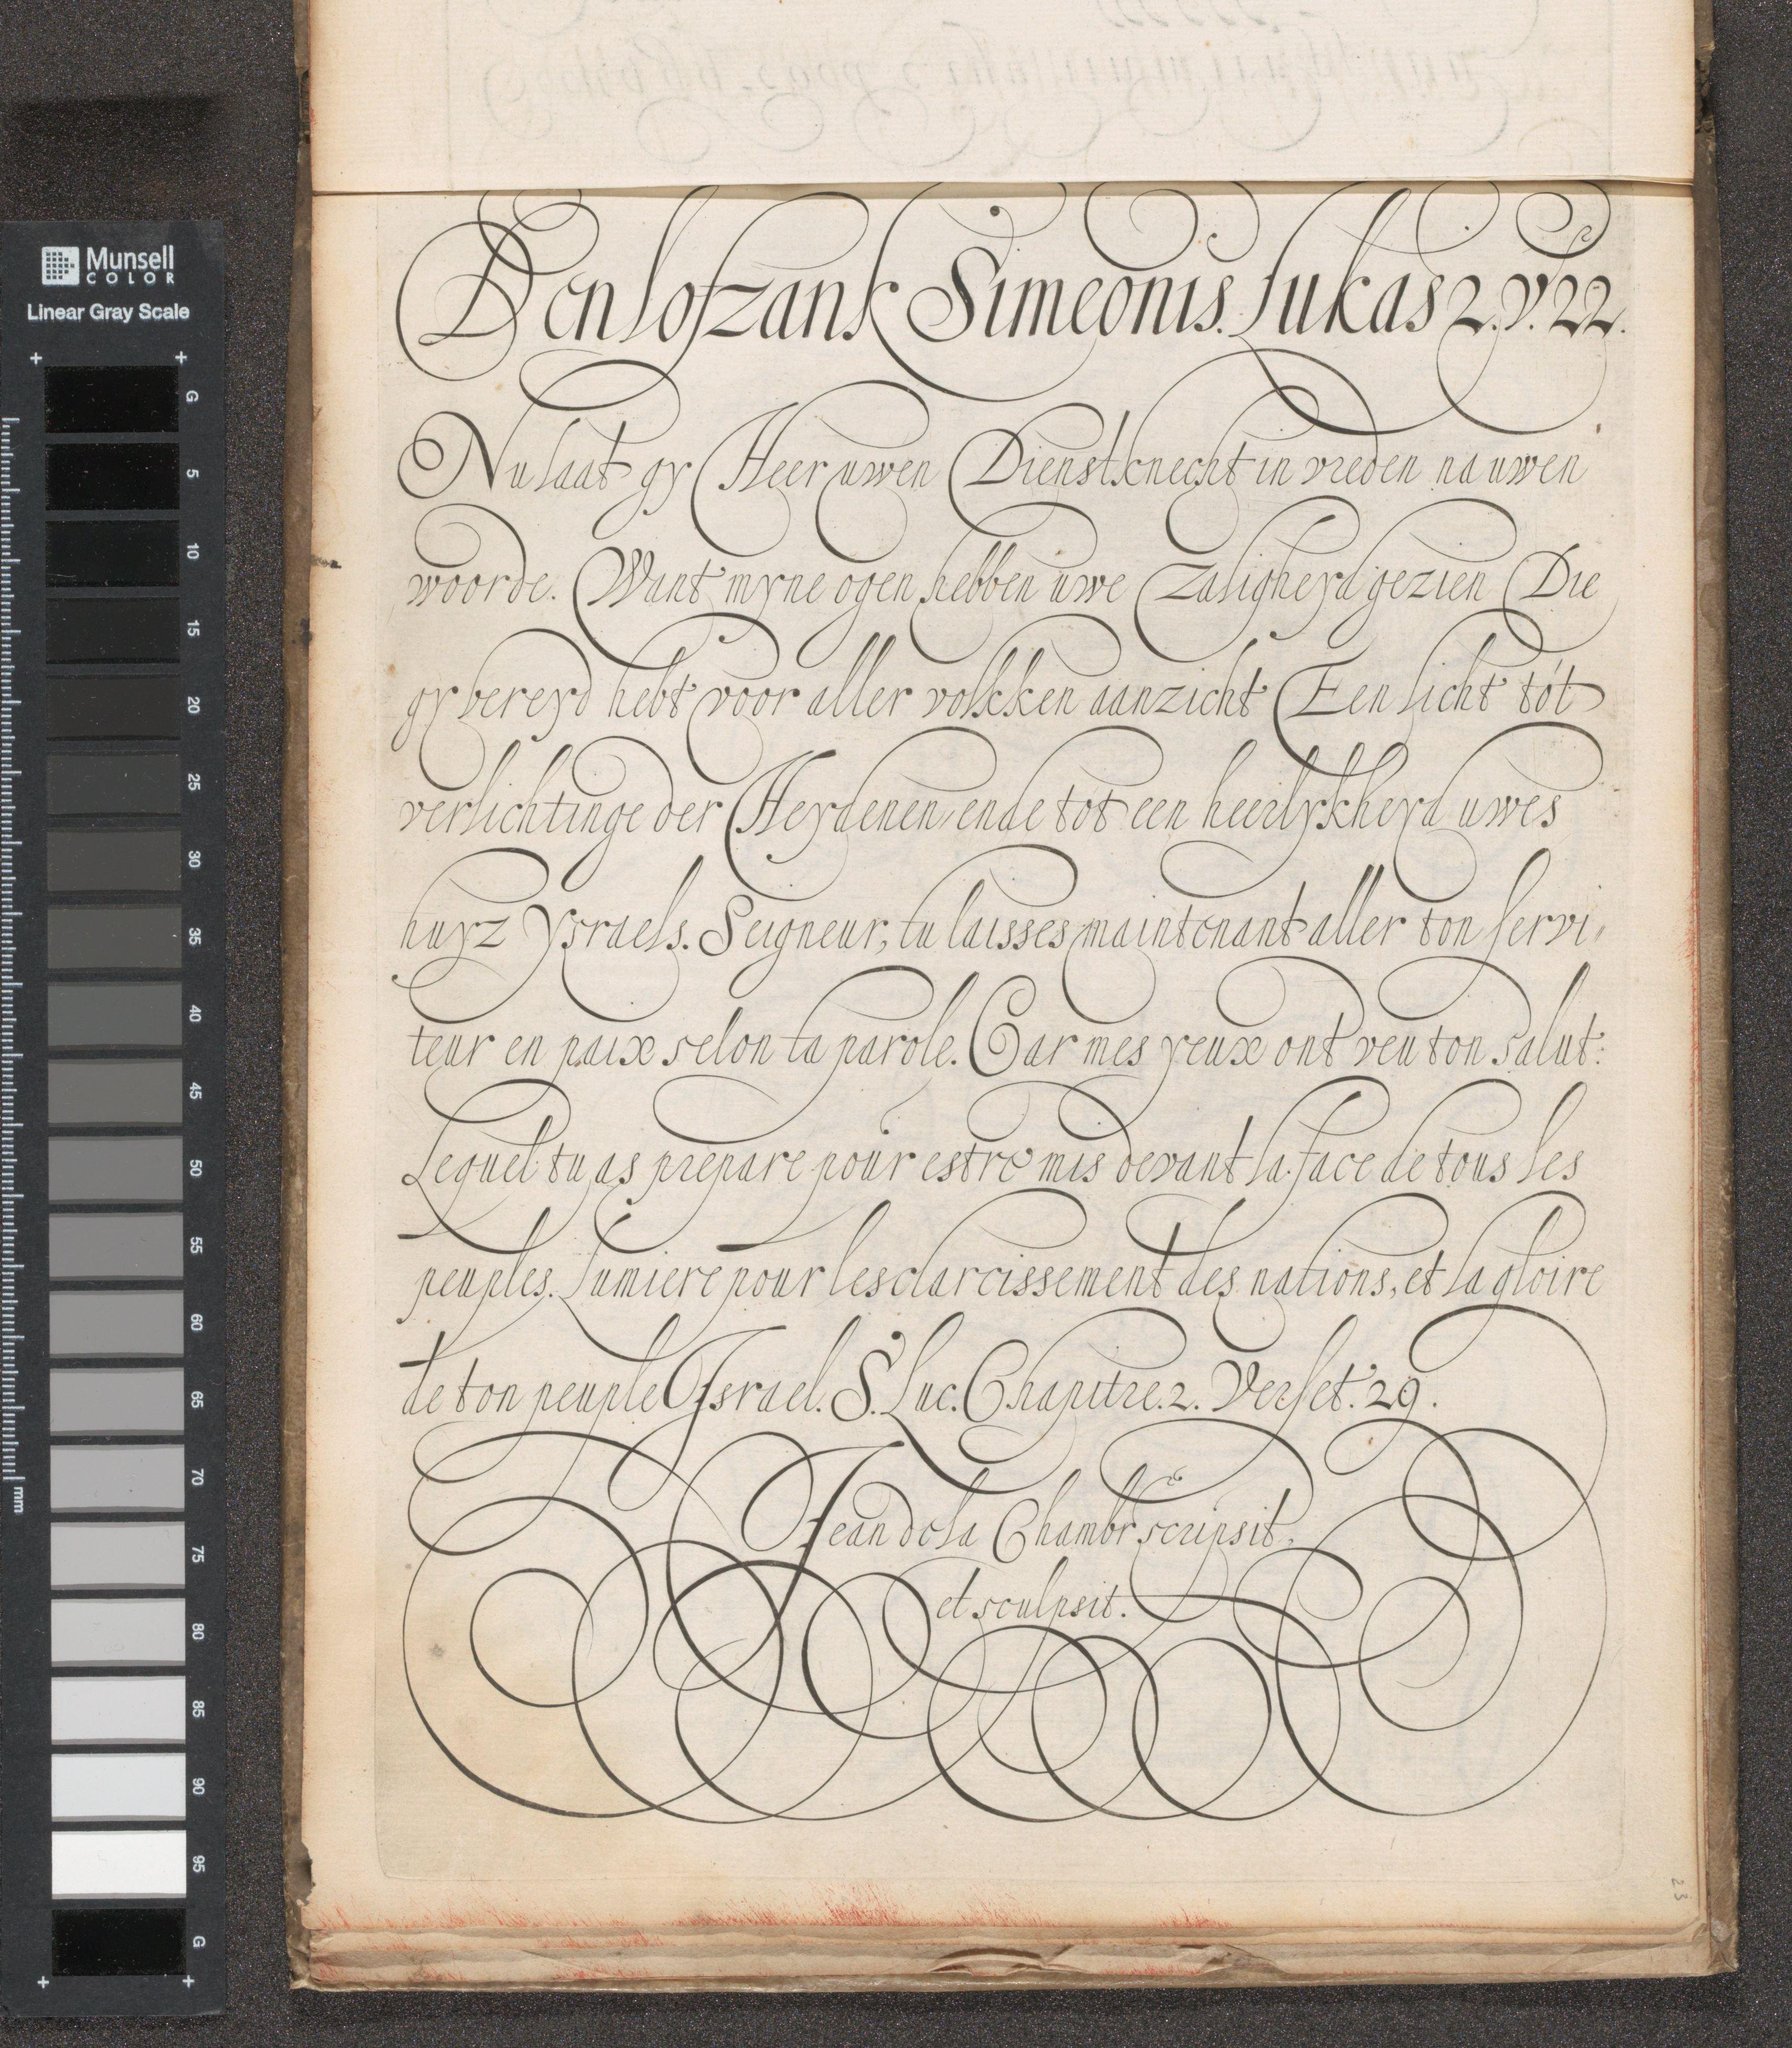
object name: album leaf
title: Exemplaar-boeck inhoudende verscheijden geschriften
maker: jean de la chambre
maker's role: draughtsman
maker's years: 1605-1668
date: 1649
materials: paper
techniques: engraving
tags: calligraphy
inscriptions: signature and date: ‘Op titelblad: Judoco Hondio celatore. Amstelodami apud Joannem Janssonium. 1614’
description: Schrijfvoorbeeld in een humanistische hand met een titel en negen regels tekst in het Nederlands. De prent maakt deel uit van een album.